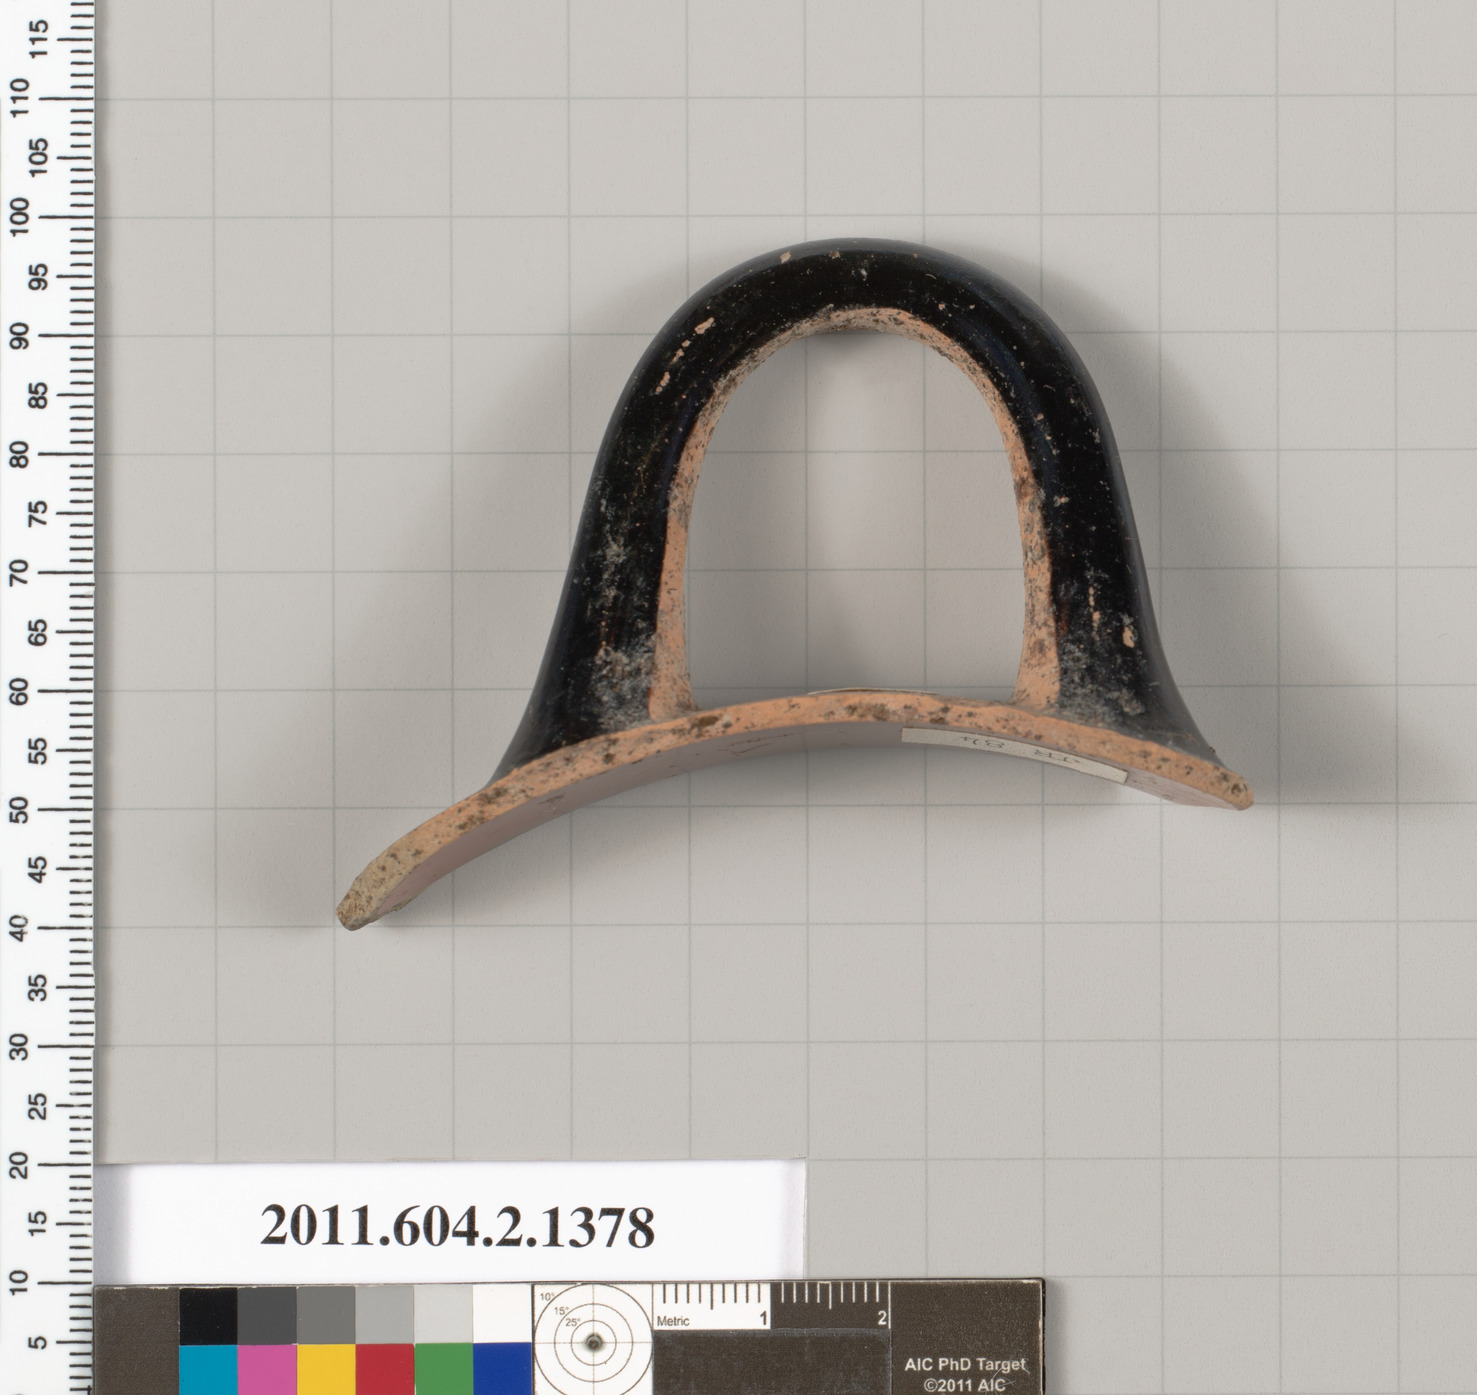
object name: skyphos fragment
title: Terracotta rim fragment of a skyphos (deep drinking cup)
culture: greek, attic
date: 475-451 BCE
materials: terracotta